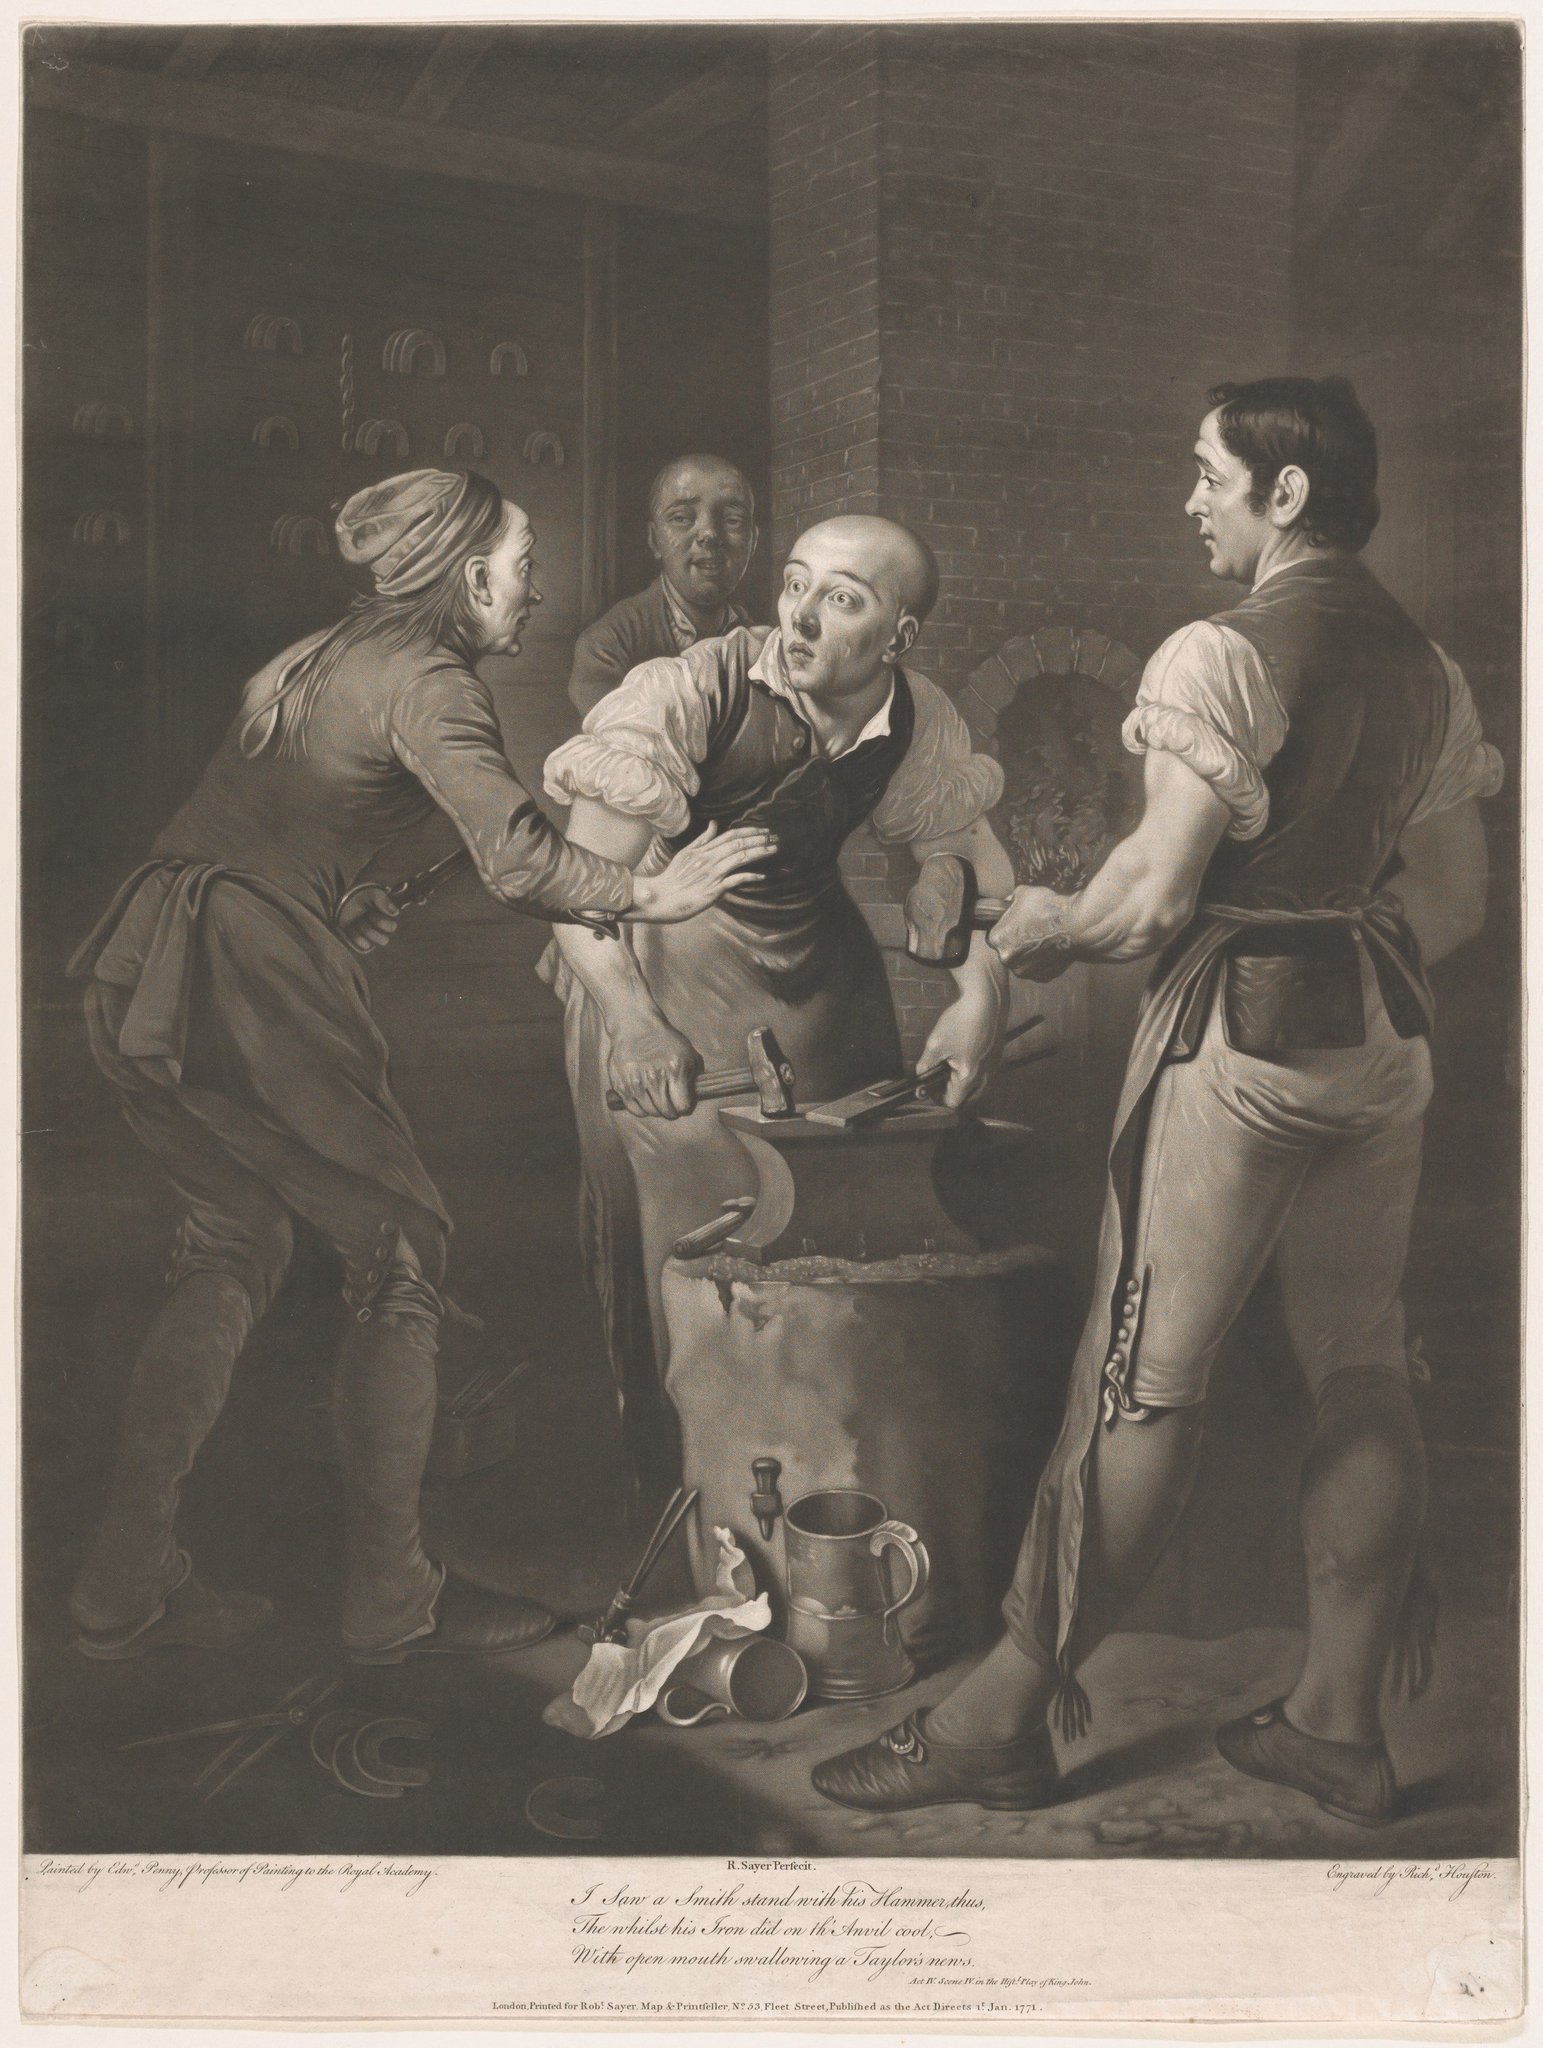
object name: print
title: "I saw a smith stand with his hammer thus..." (Shakespeare, King John, Act 4, Scene 2)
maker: richard houston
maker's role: engraver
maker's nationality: irish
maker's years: 1721-1775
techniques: mezzotint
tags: shakespeare,men,hammers